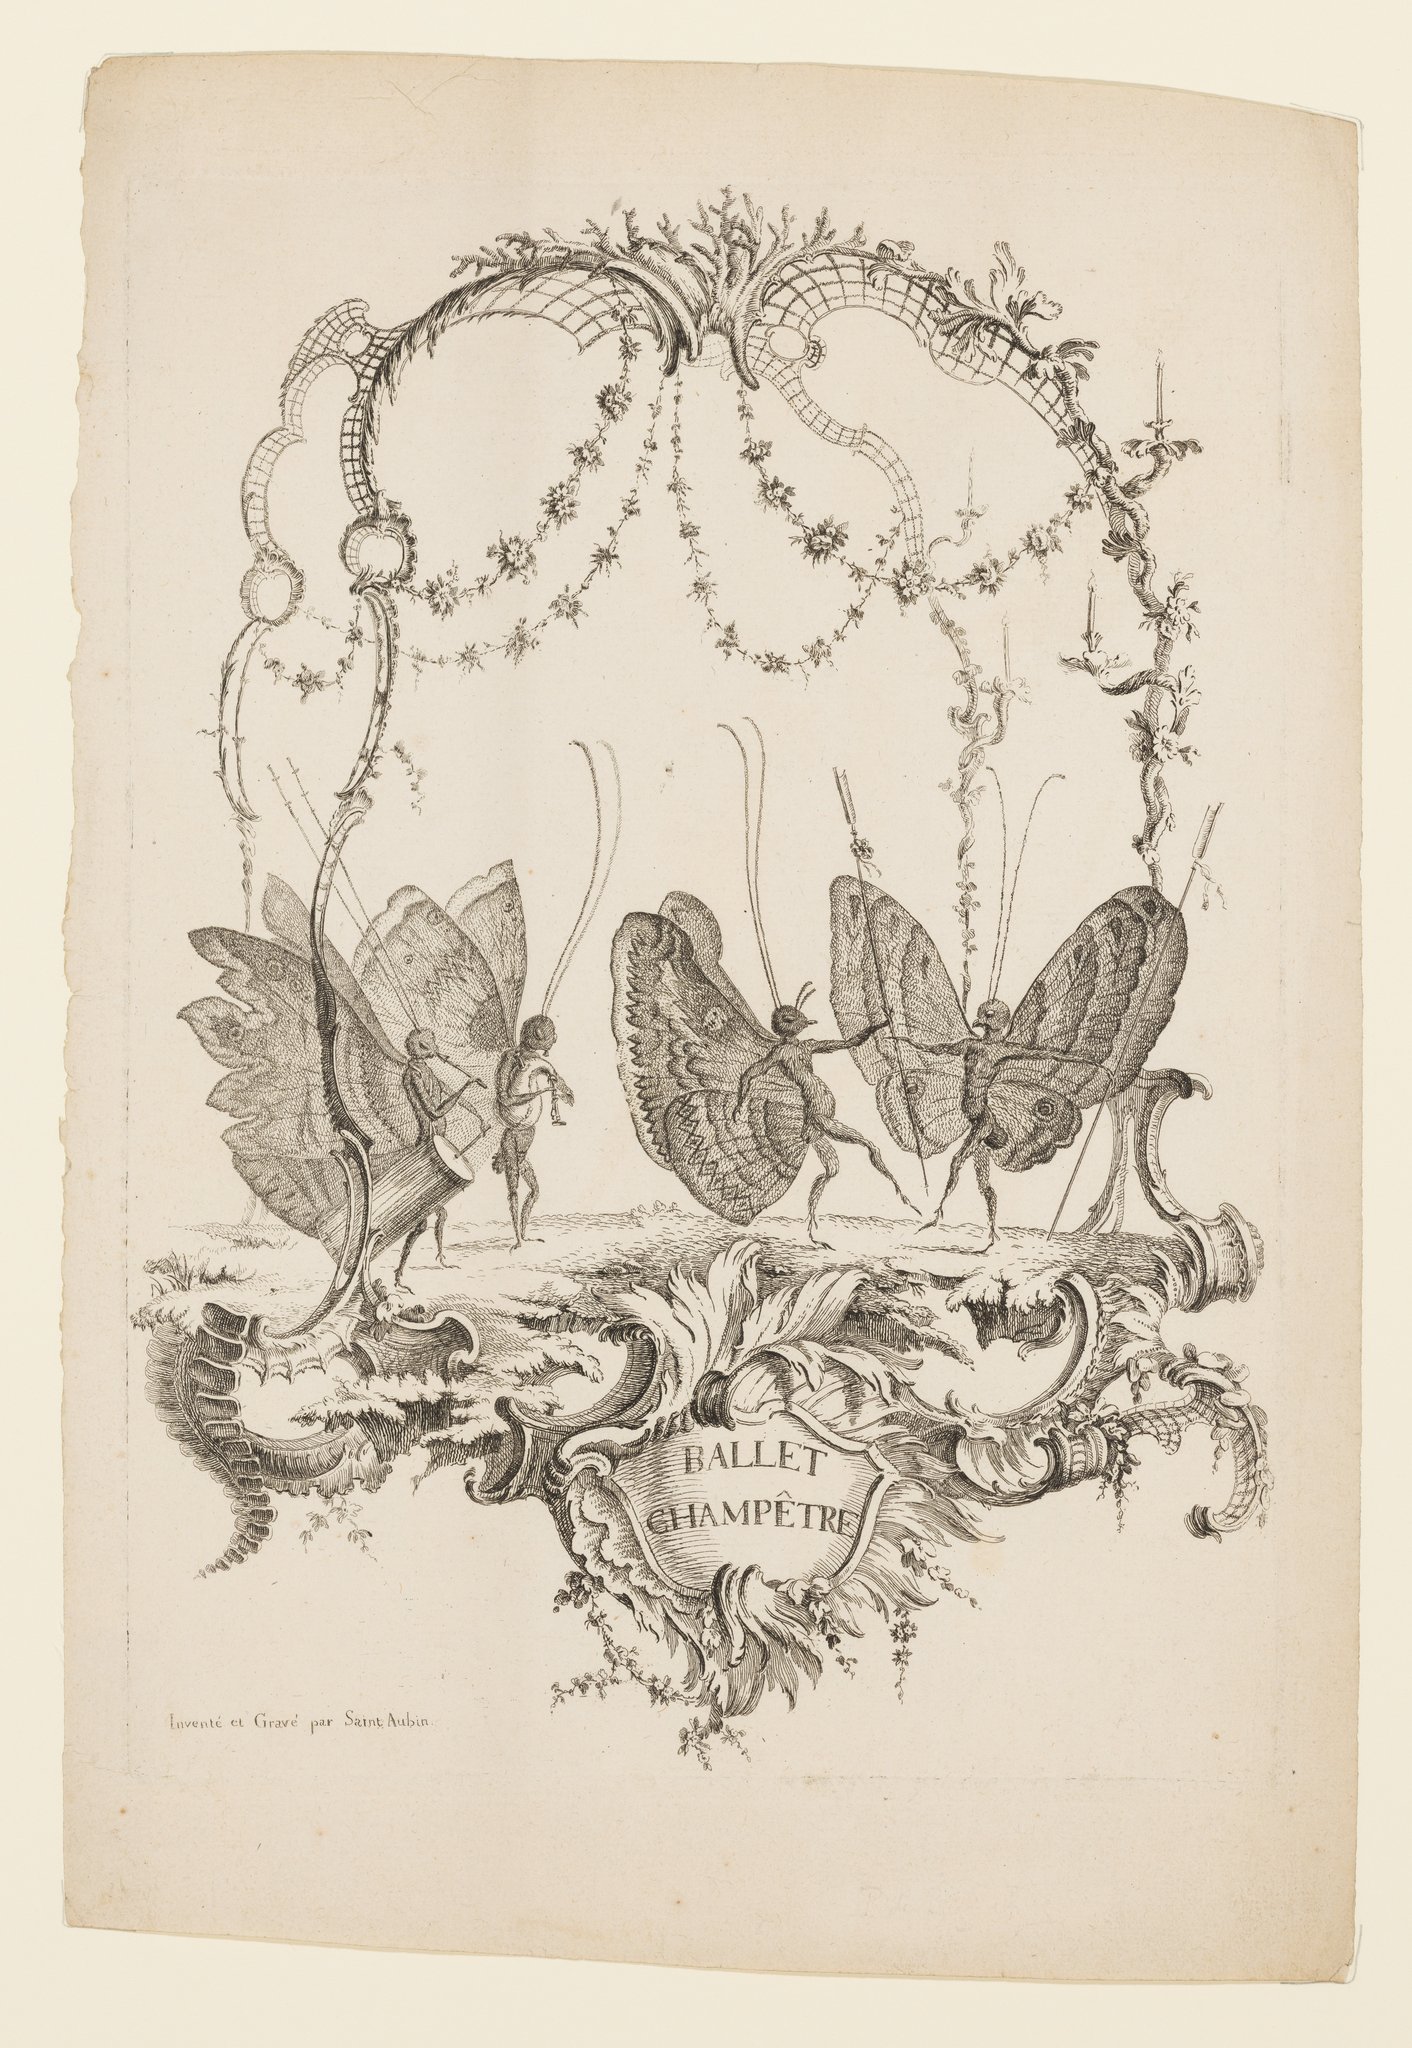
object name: print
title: Country Ballet (Ballet Champêtre), from Essai de Papilloneries Humaines par Saint Aubin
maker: charles germain de saint-aubin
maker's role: artist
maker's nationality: french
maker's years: 1721-1786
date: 1756-1760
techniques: etching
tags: dance,dancing,butterflies,ballet